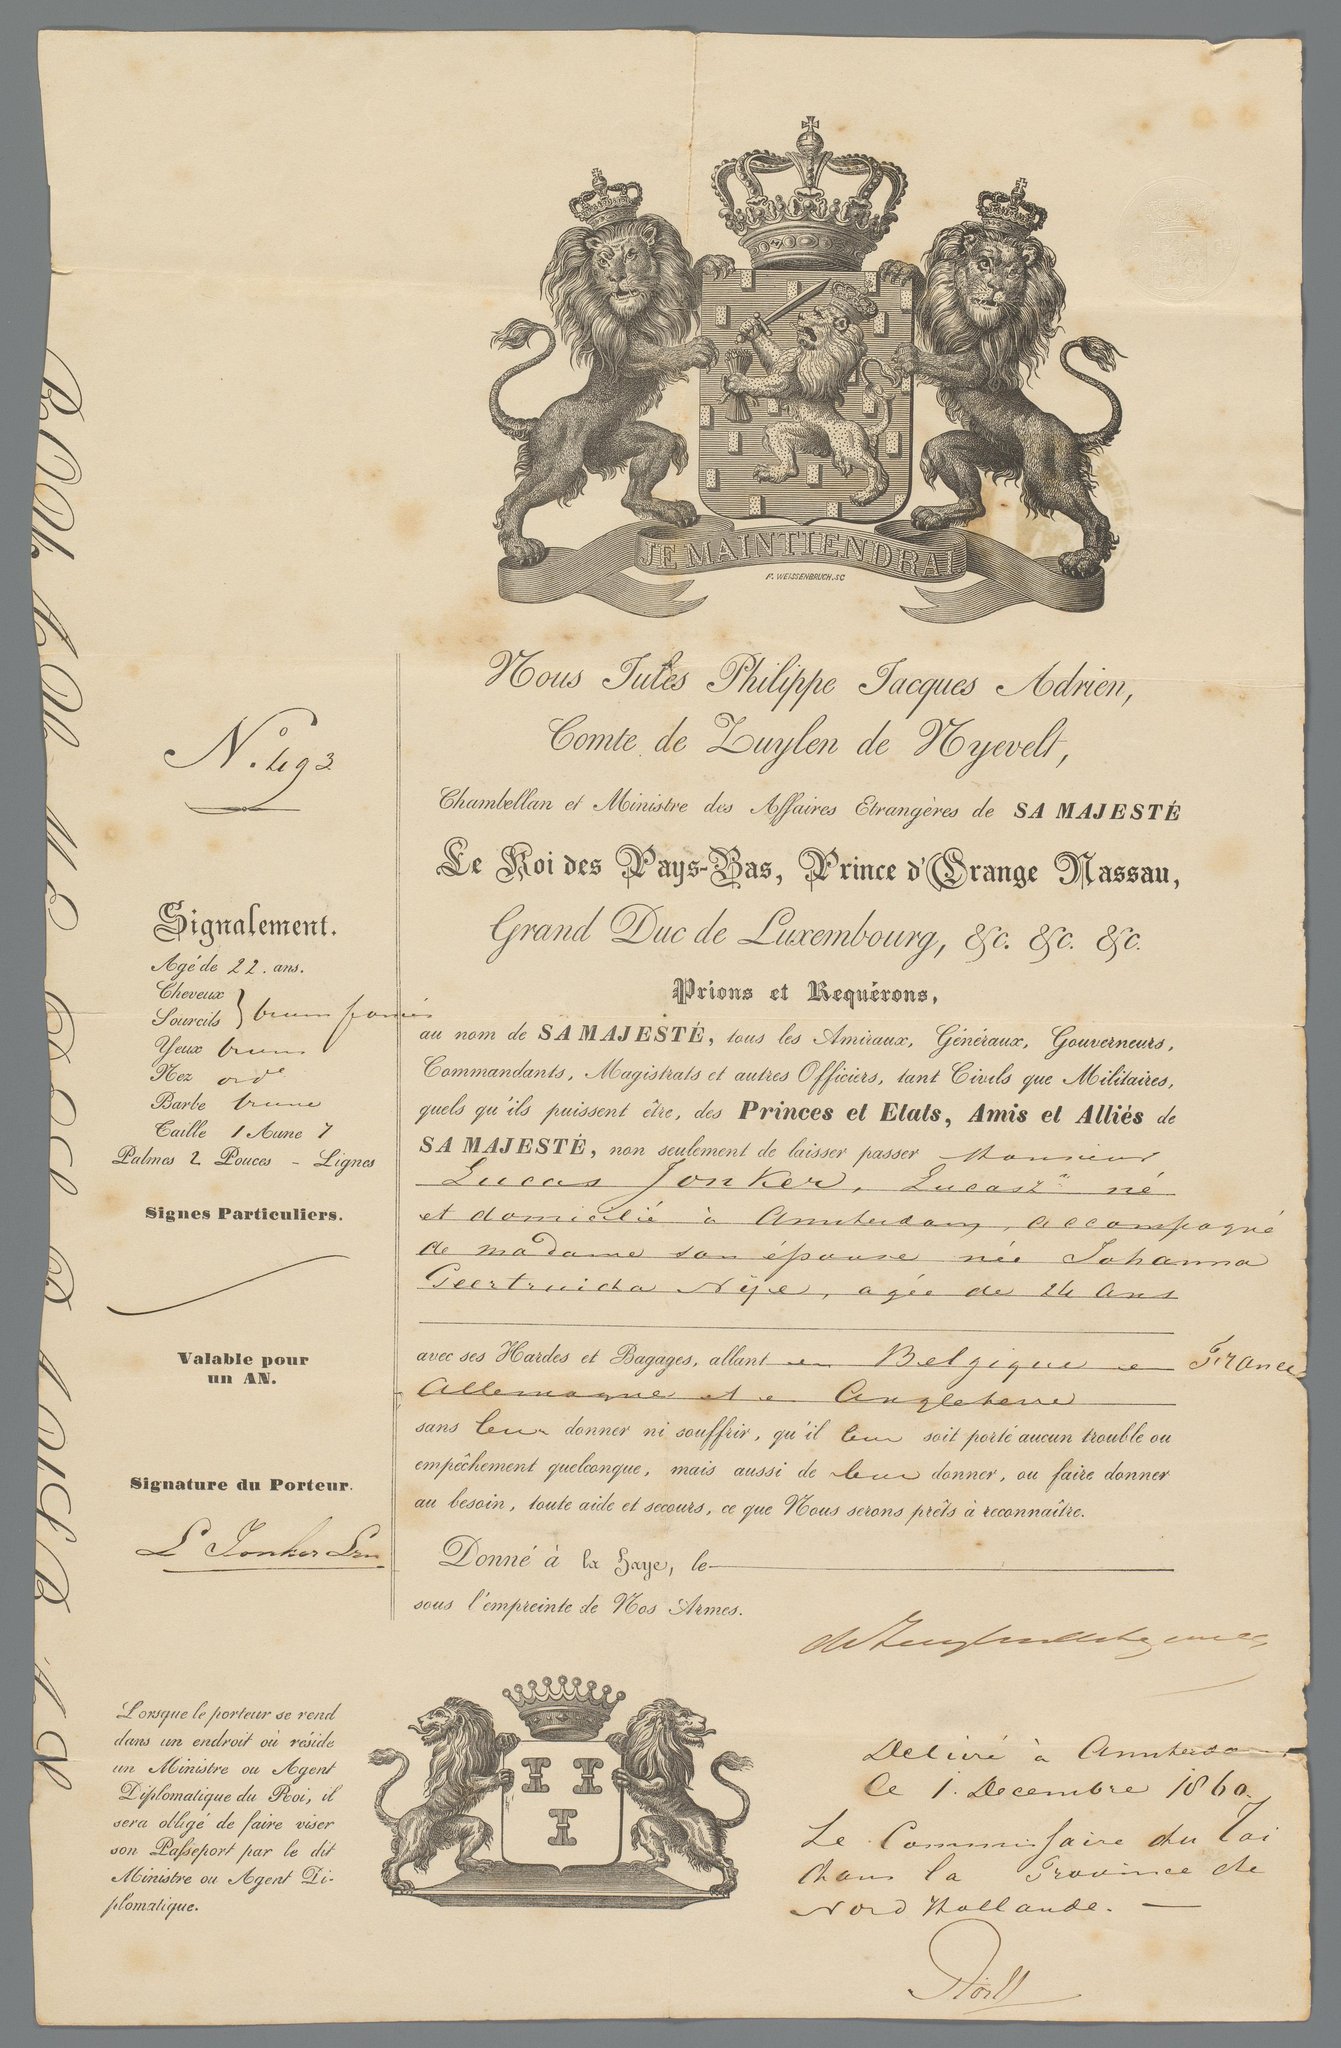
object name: passport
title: Paspoort Lucas Jonker Lucasz. en echtgenote Geertruida Nije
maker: frederik hendrik weissenbruch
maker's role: draughtsman, print maker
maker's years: 1828-1887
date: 1850-1860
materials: ink, paper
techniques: pen, engraving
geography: netherlands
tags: earl, amsterdam, passport, visa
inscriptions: stamp, stamp: ‘Consulat general de France a Amsterdam’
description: Paspoort uitgegeven voor Lucas Jonker Lucasz. en zijn echtgenote Johanna Geertruida Nije, 1 december 1860. Om vrij te kunnen reizen door België, Duitsland, Frankrijk en Engeland. Voorgedrukt formulier met de hand ingevuld door minister van buitenlandse zaken Julius Philip Jacob Adriaan van Zuylen van Nijevelt namens de koning Willem III.